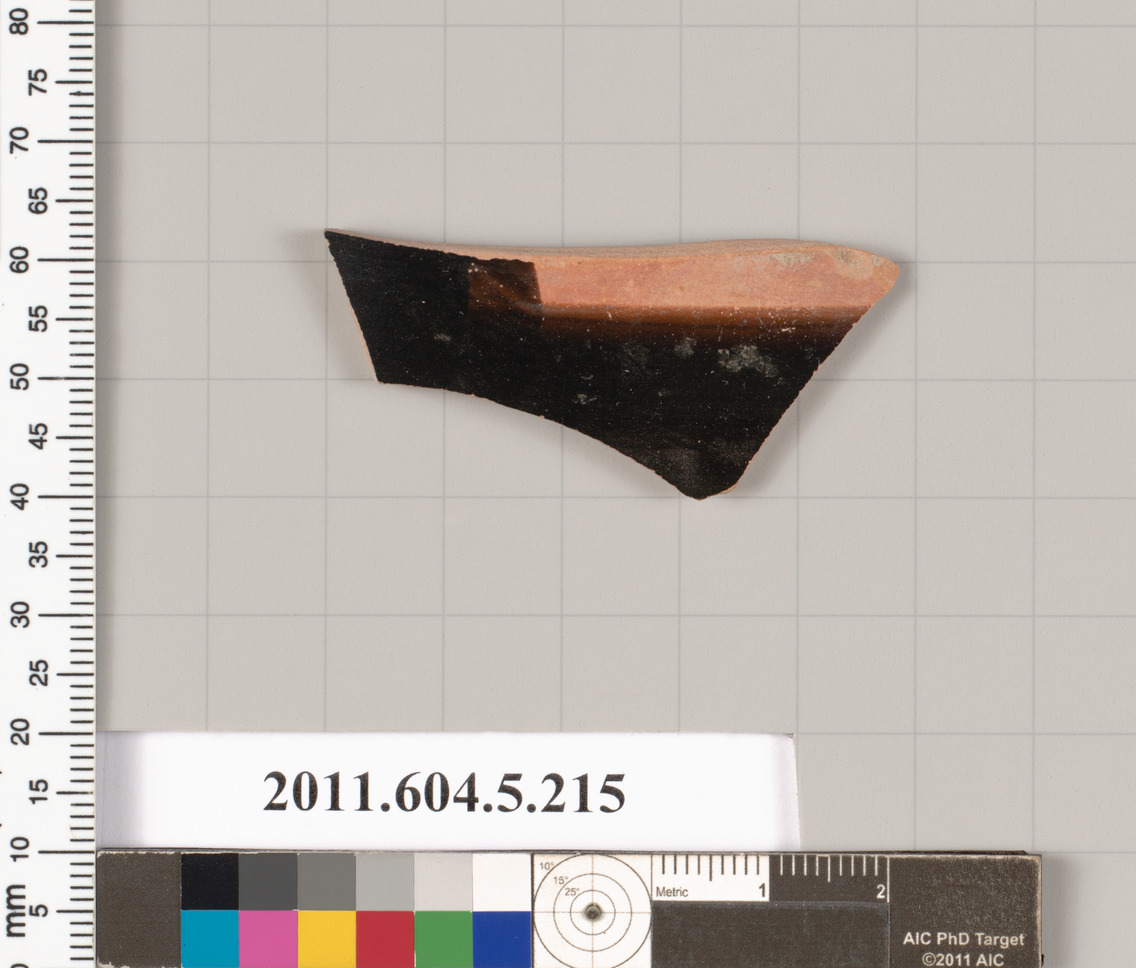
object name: kylix fragment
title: Terracotta fragment of a kylix (drinking cup)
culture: greek, attic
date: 600-401 BCE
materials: terracotta